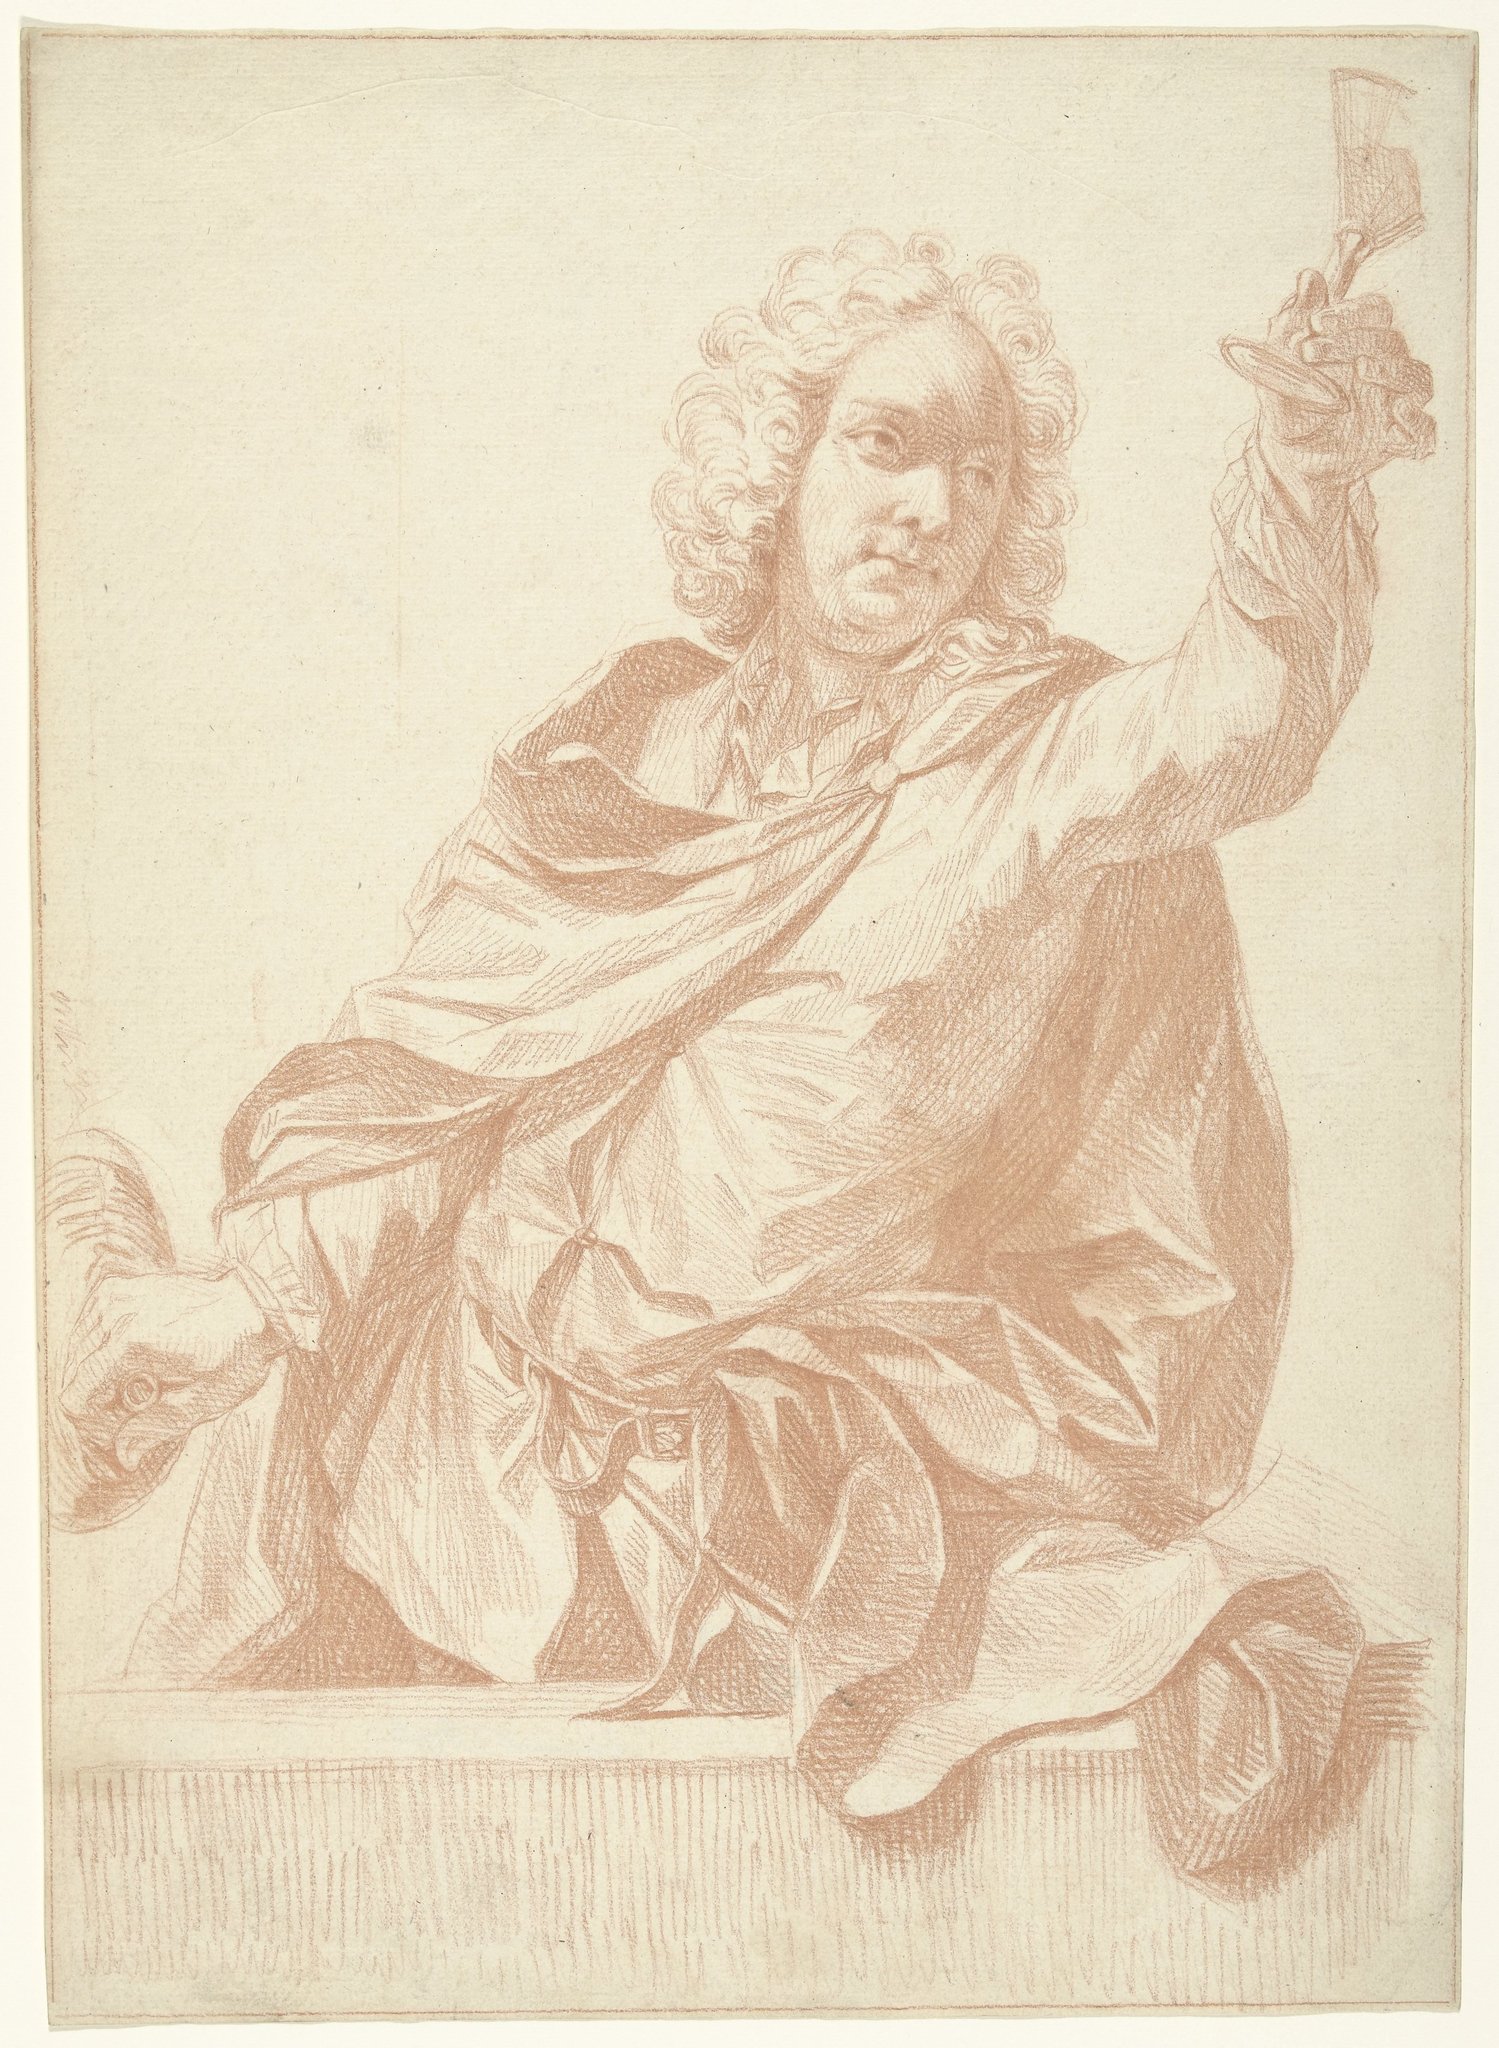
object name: drawing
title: Staande drinker met opgeheven glas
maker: Anonymous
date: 1700-1800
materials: chalk, paper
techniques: printmaking